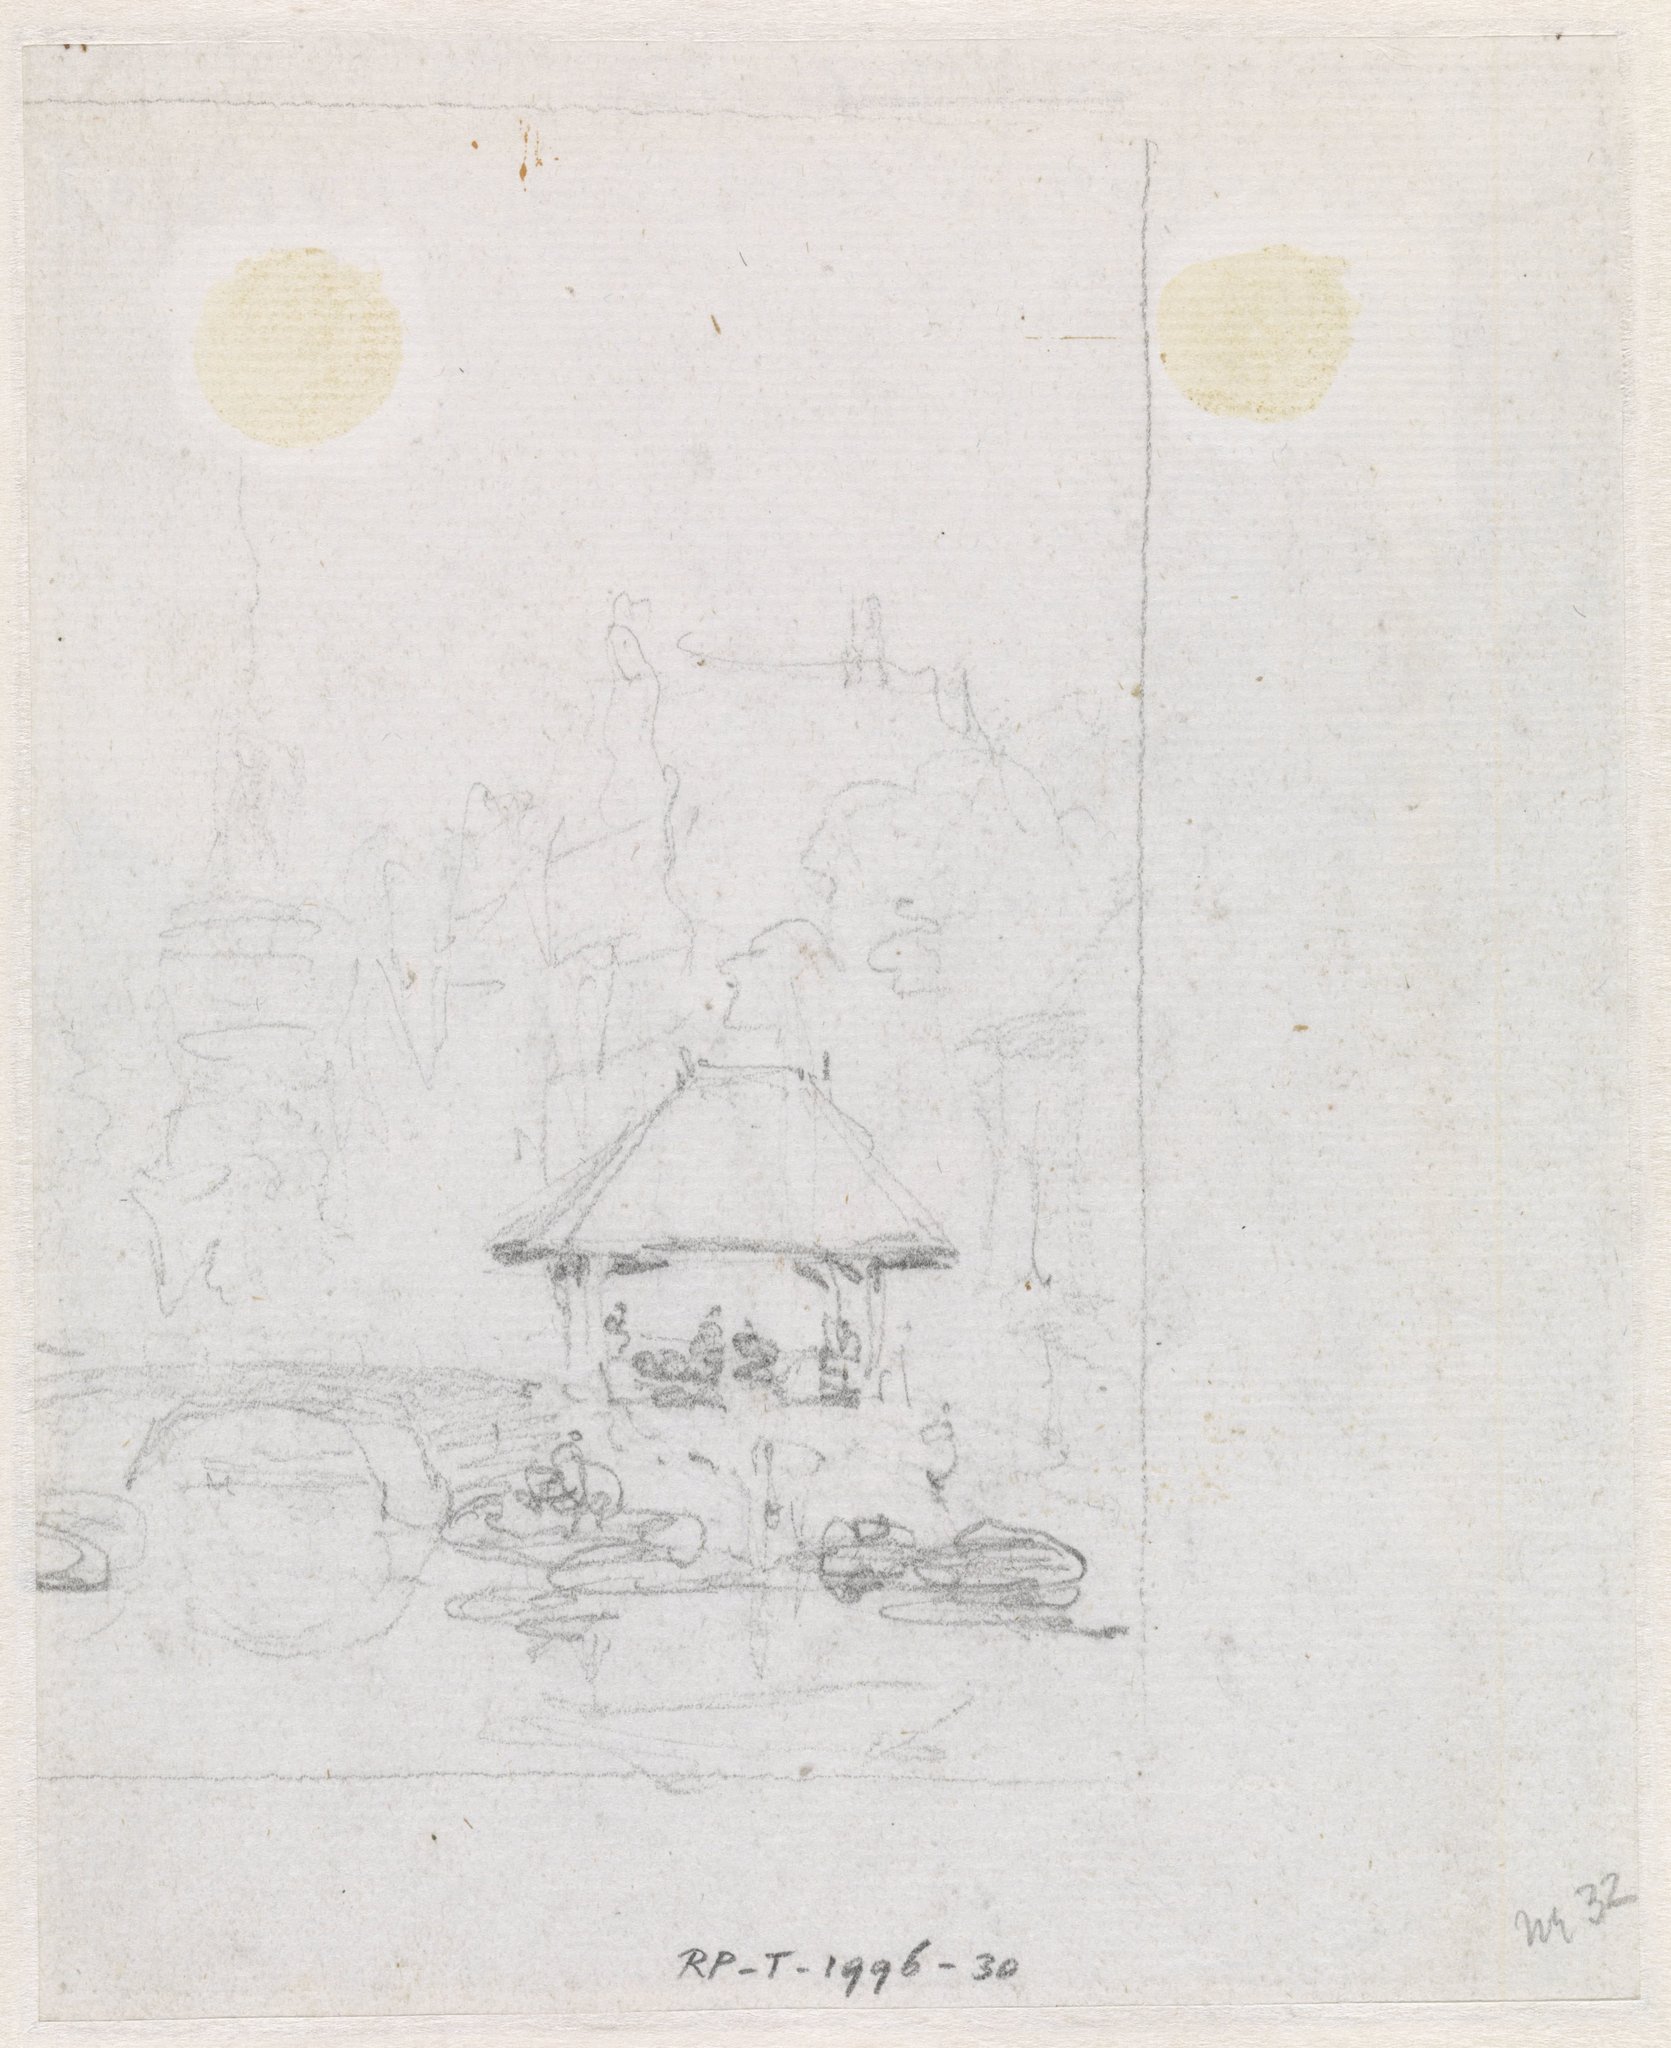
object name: drawing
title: Krabbel van een landschap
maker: adrianus eversen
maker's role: draughtsman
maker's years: 1818-1897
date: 1828-1897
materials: paper, pencil